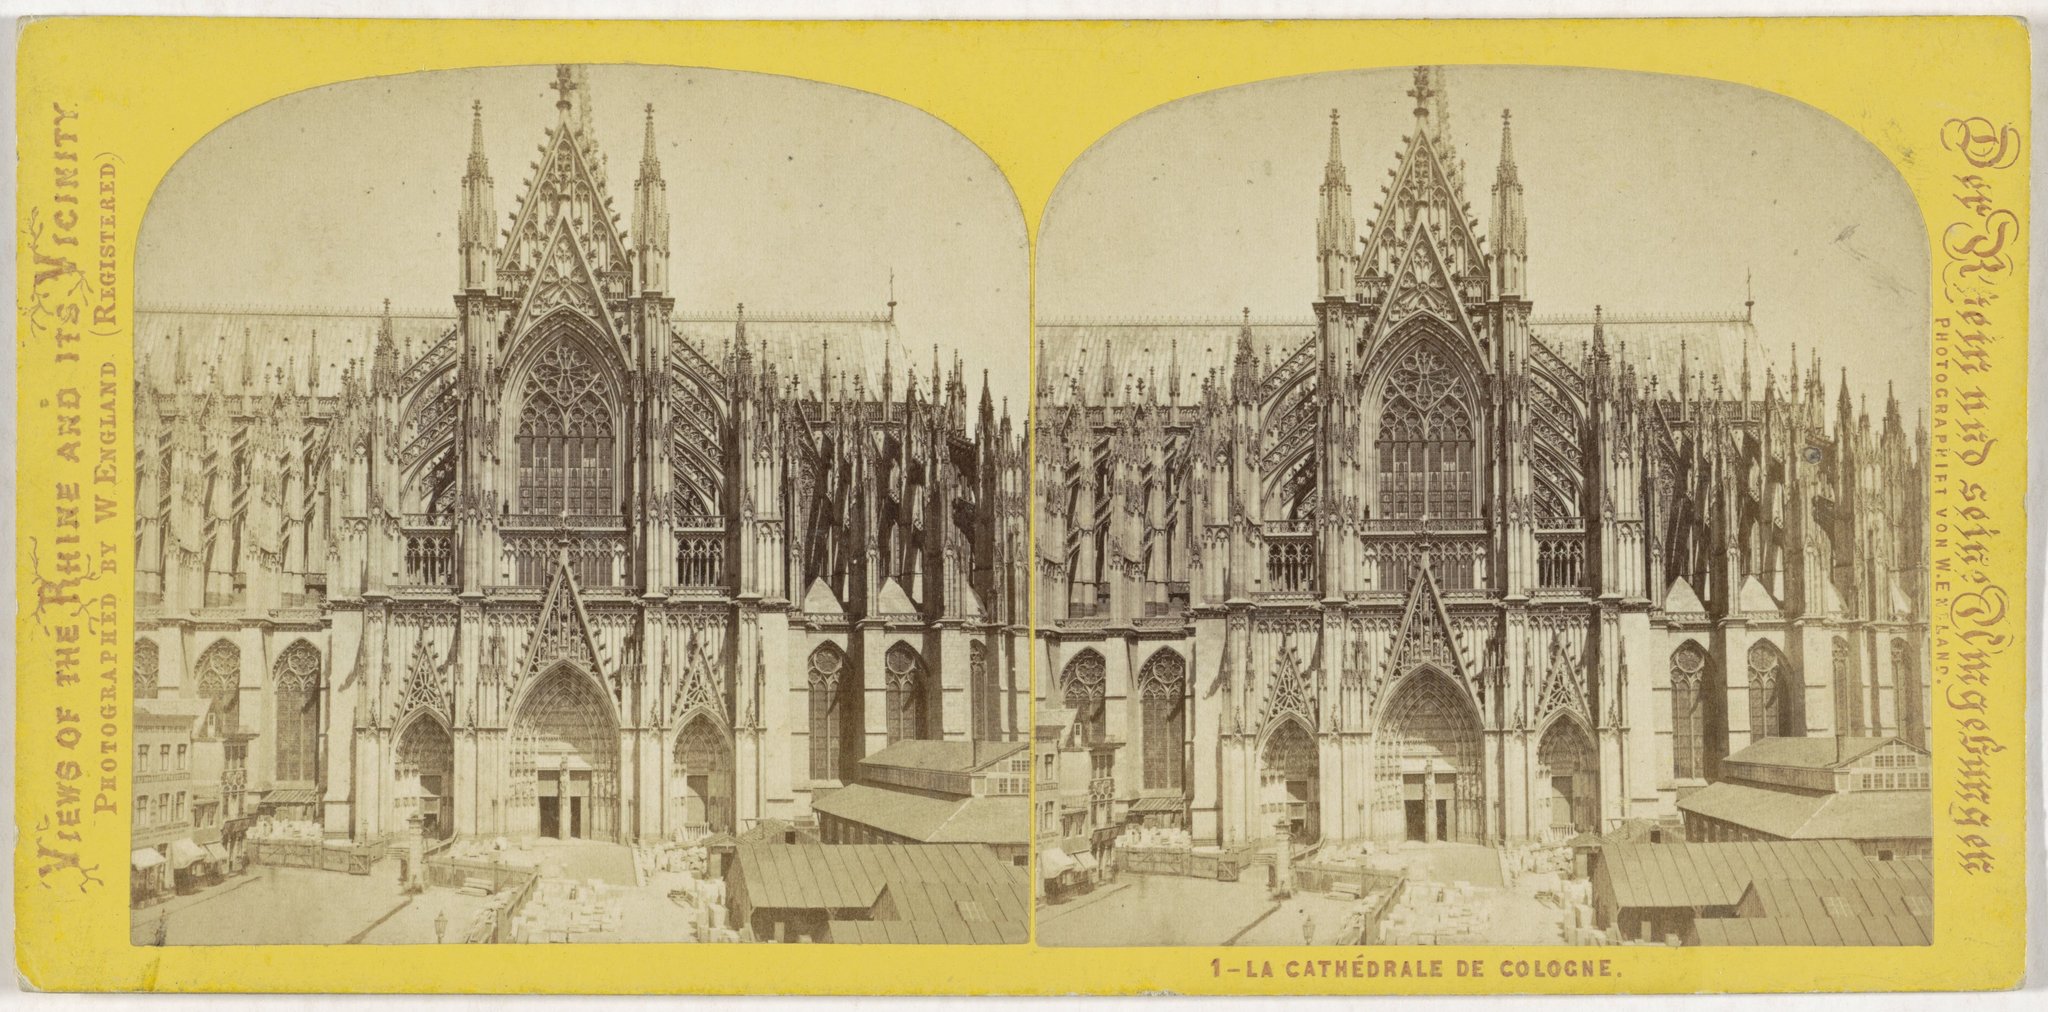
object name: stereograph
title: La Cathédrale de Cologne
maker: william england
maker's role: fotograaf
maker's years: 1816-1896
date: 1867-1868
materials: cardboard, paper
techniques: albumen print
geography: cologne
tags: parts of church exterior and annexes: portal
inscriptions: number: ‘1’